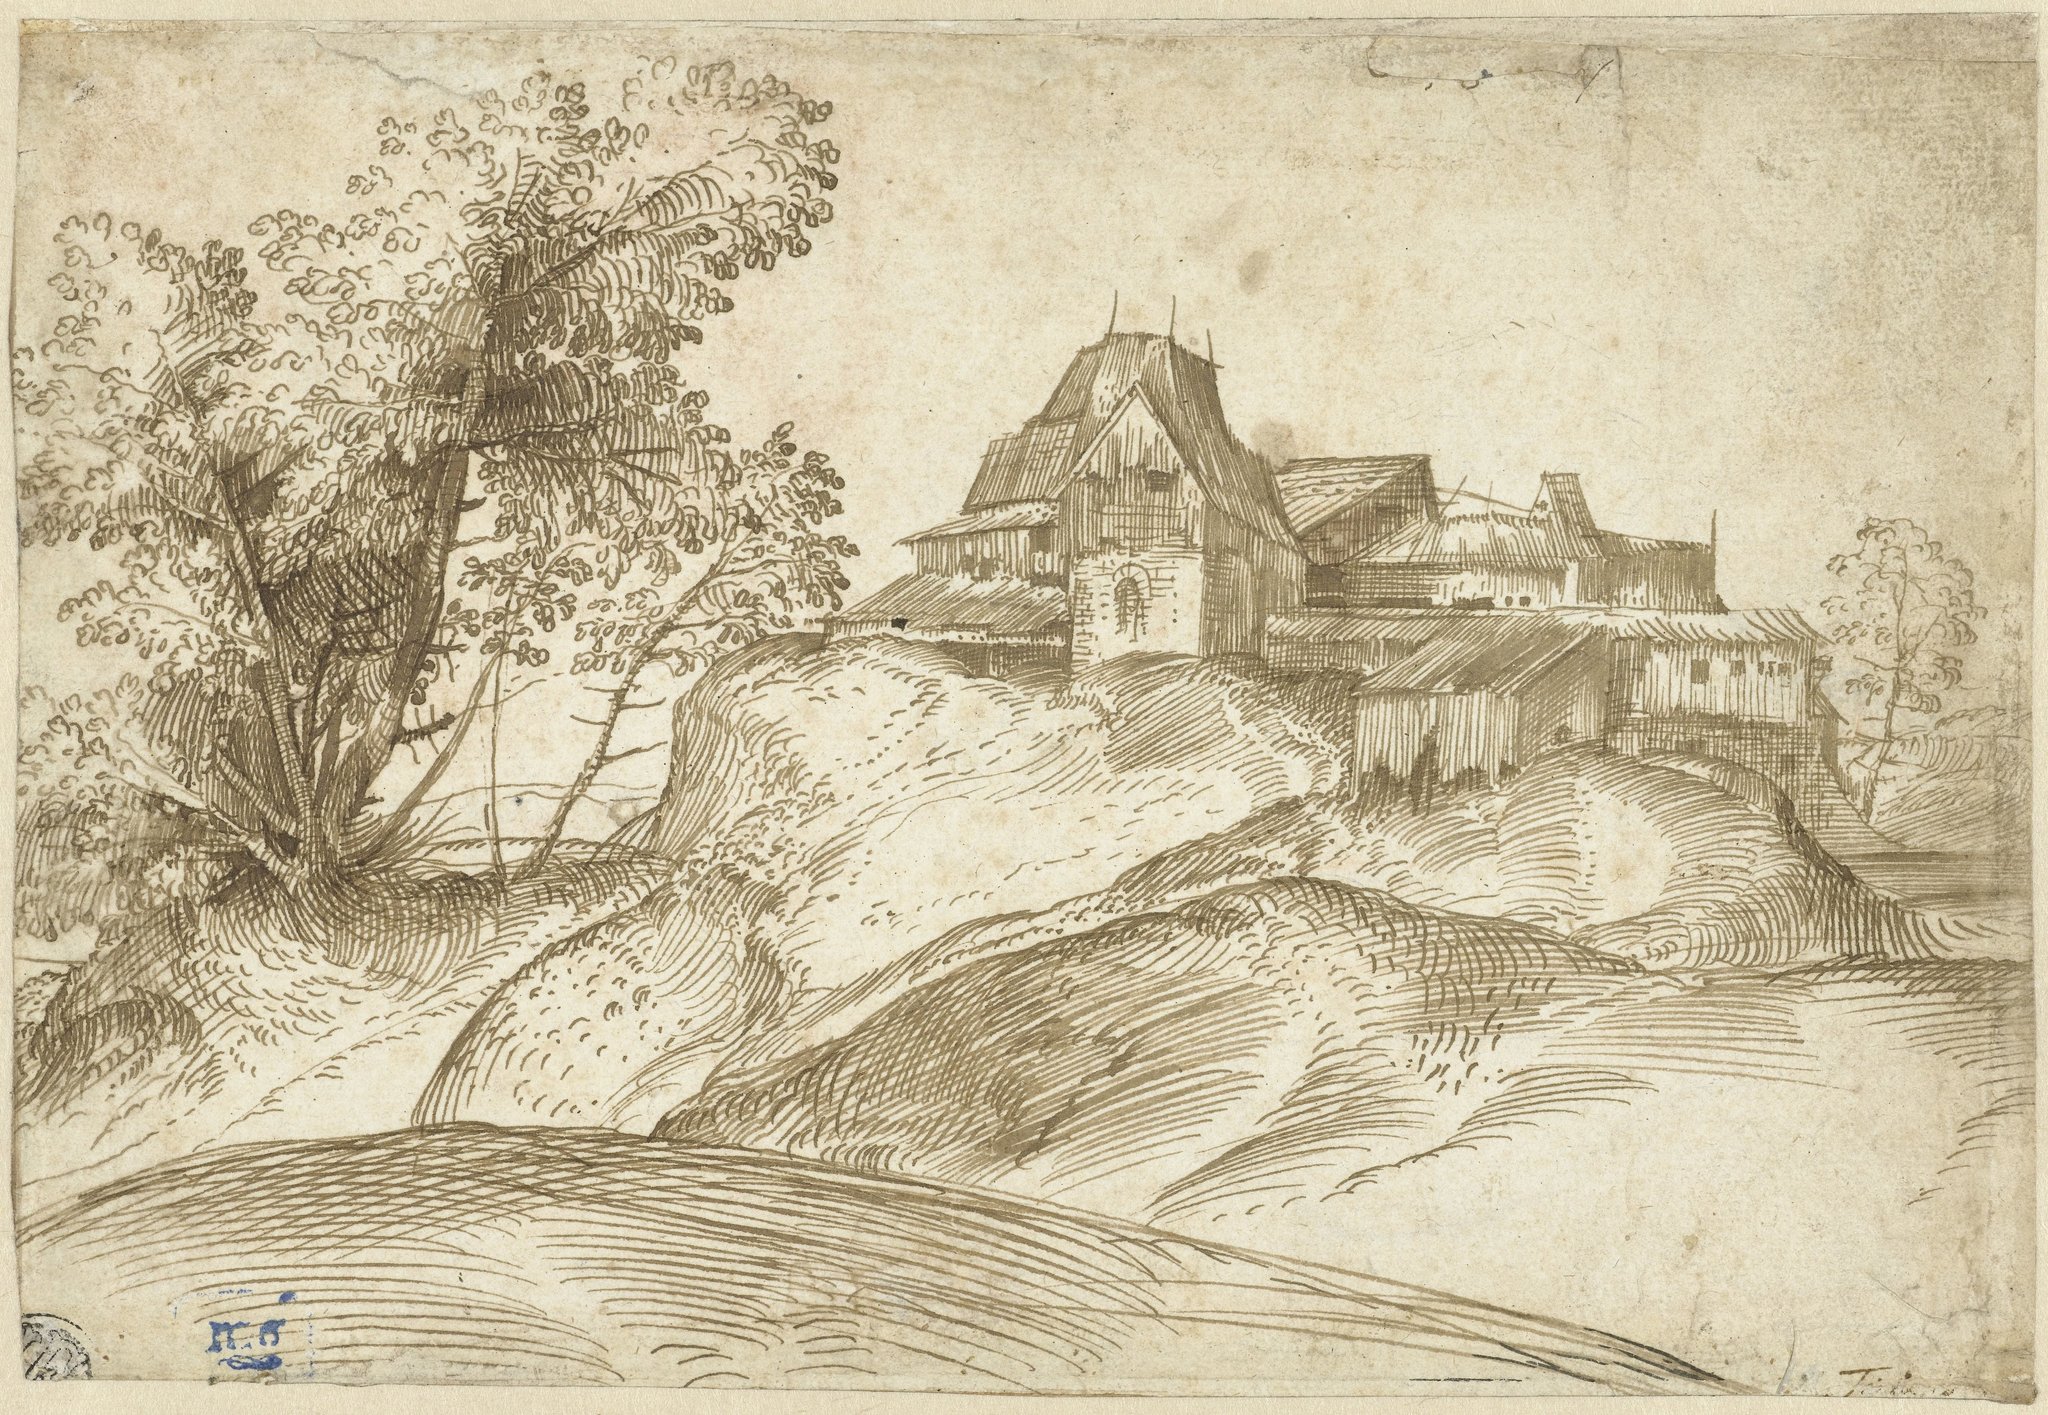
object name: drawing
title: Settlement on a Hill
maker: domenico campagnola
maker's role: draughtsman, painter, print maker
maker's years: 1500-1564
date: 1520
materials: ink, paper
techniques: pen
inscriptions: collector's mark: Lugt 4181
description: Domenico Campagnola built up the composition of this hilly landscape diagonally from left to right. Typical of his drawing style is the way in which he suggested shadows with parallel hatching. He left some parts completely empty, such as the sky and passages of the foreground. He had adopted this way of drawing from Titian, one of the great innovators of 16th-century landscape art.